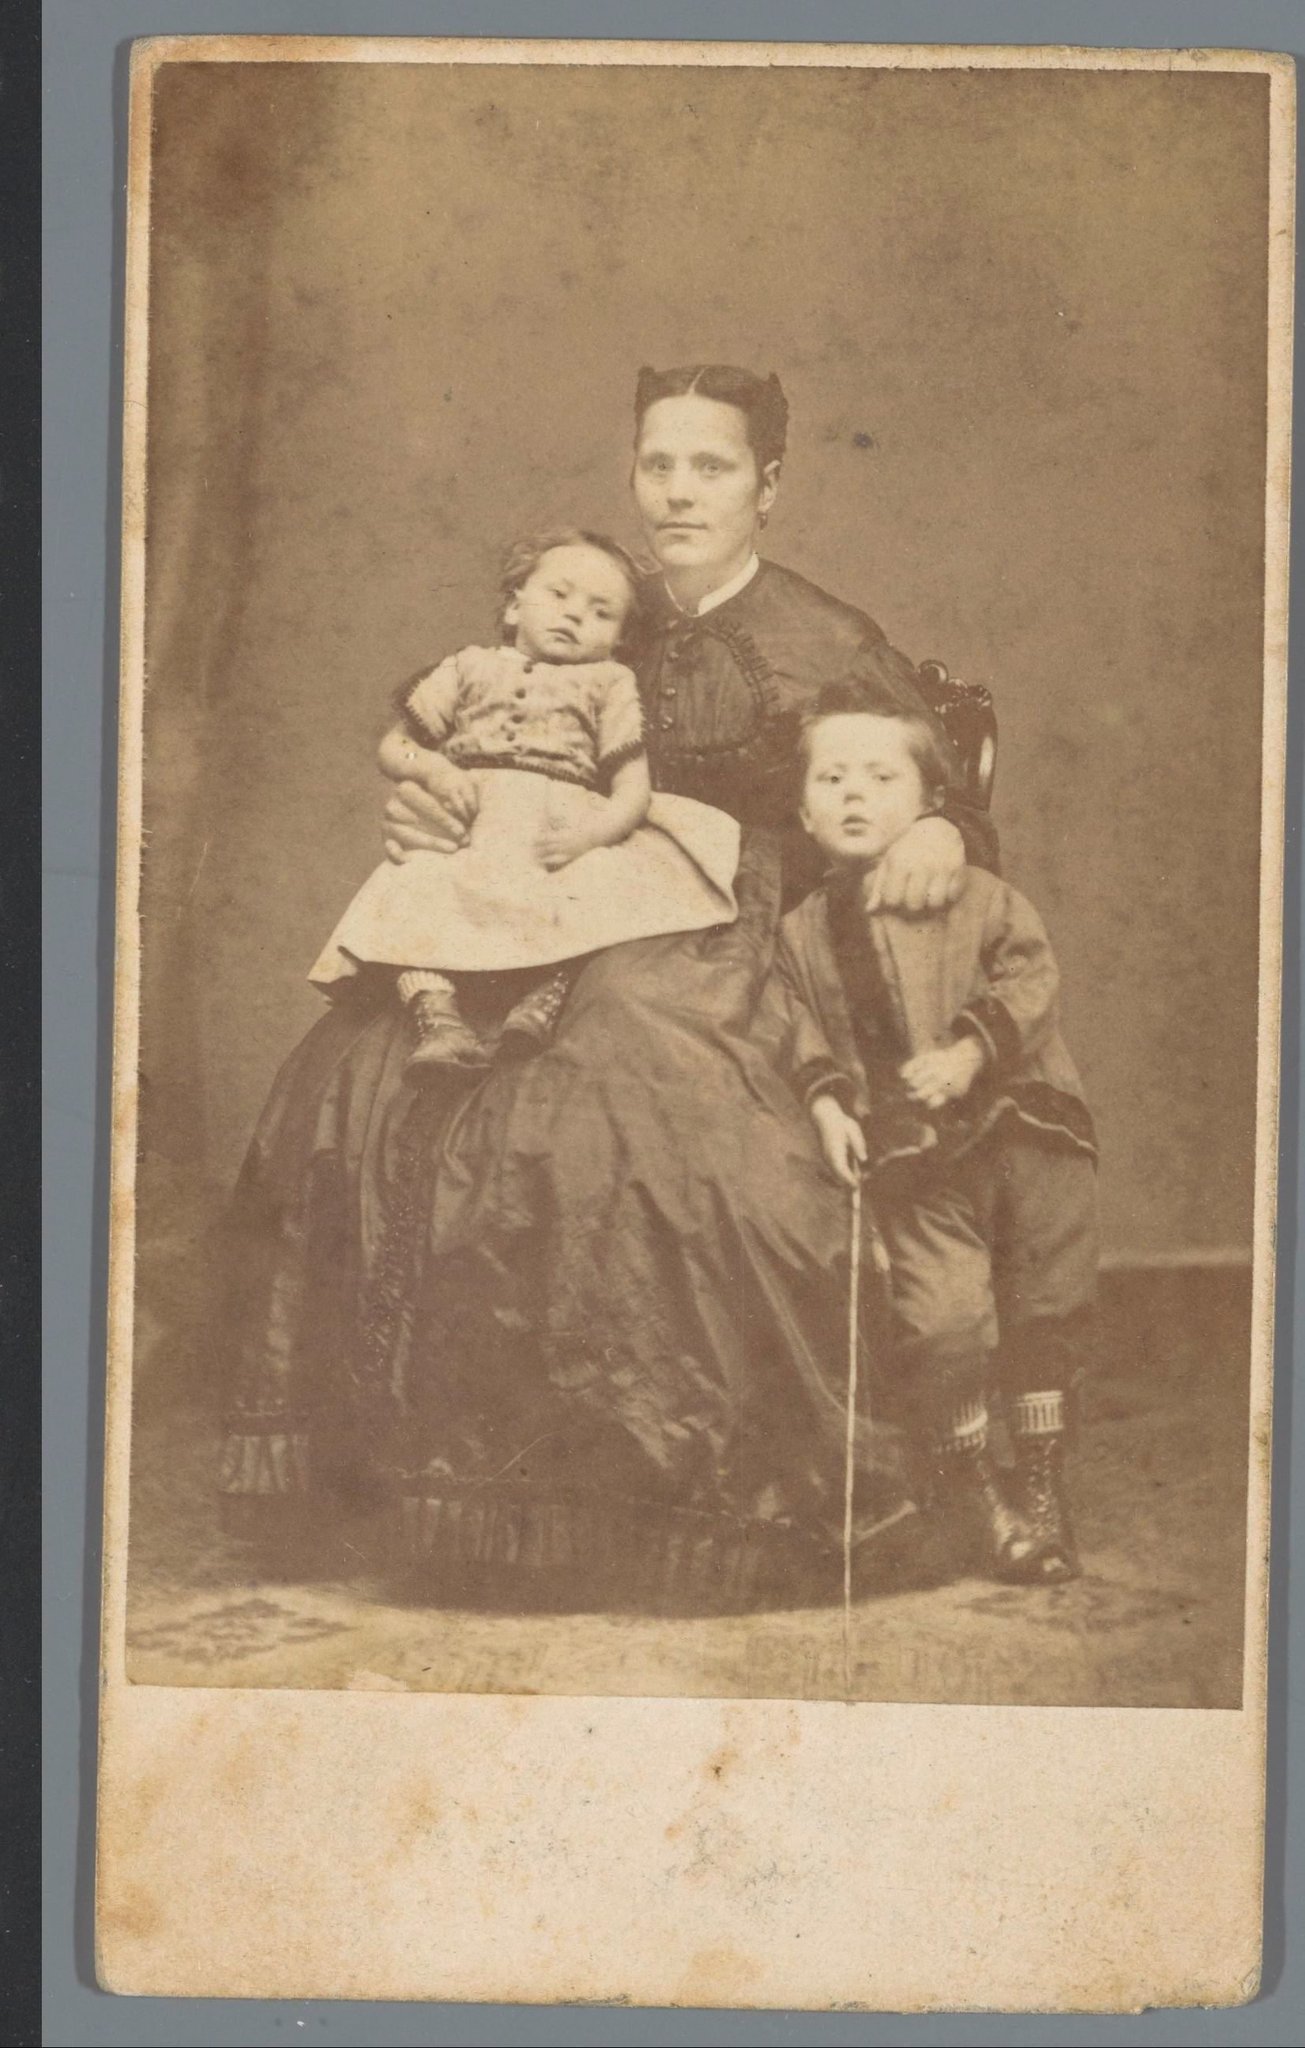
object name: photograph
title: Portret van Truus van Leeuwen met haar kinderen Dirk en Teun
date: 1867-1870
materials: cardboard, paper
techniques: albumen print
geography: amsterdam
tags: historical persons, mother and child(ren), woman and child(ren) (family group), amsterdam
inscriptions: inscription: ‘Dit is Moeder/ met de kinderen/ Truus/ Moeder v Leeuwen/ met Dirk en Teun’, inscription: ‘Photographie/ Stapert & V. Caspel/ Bloem Gracht DD 43/ Amsterdam.’